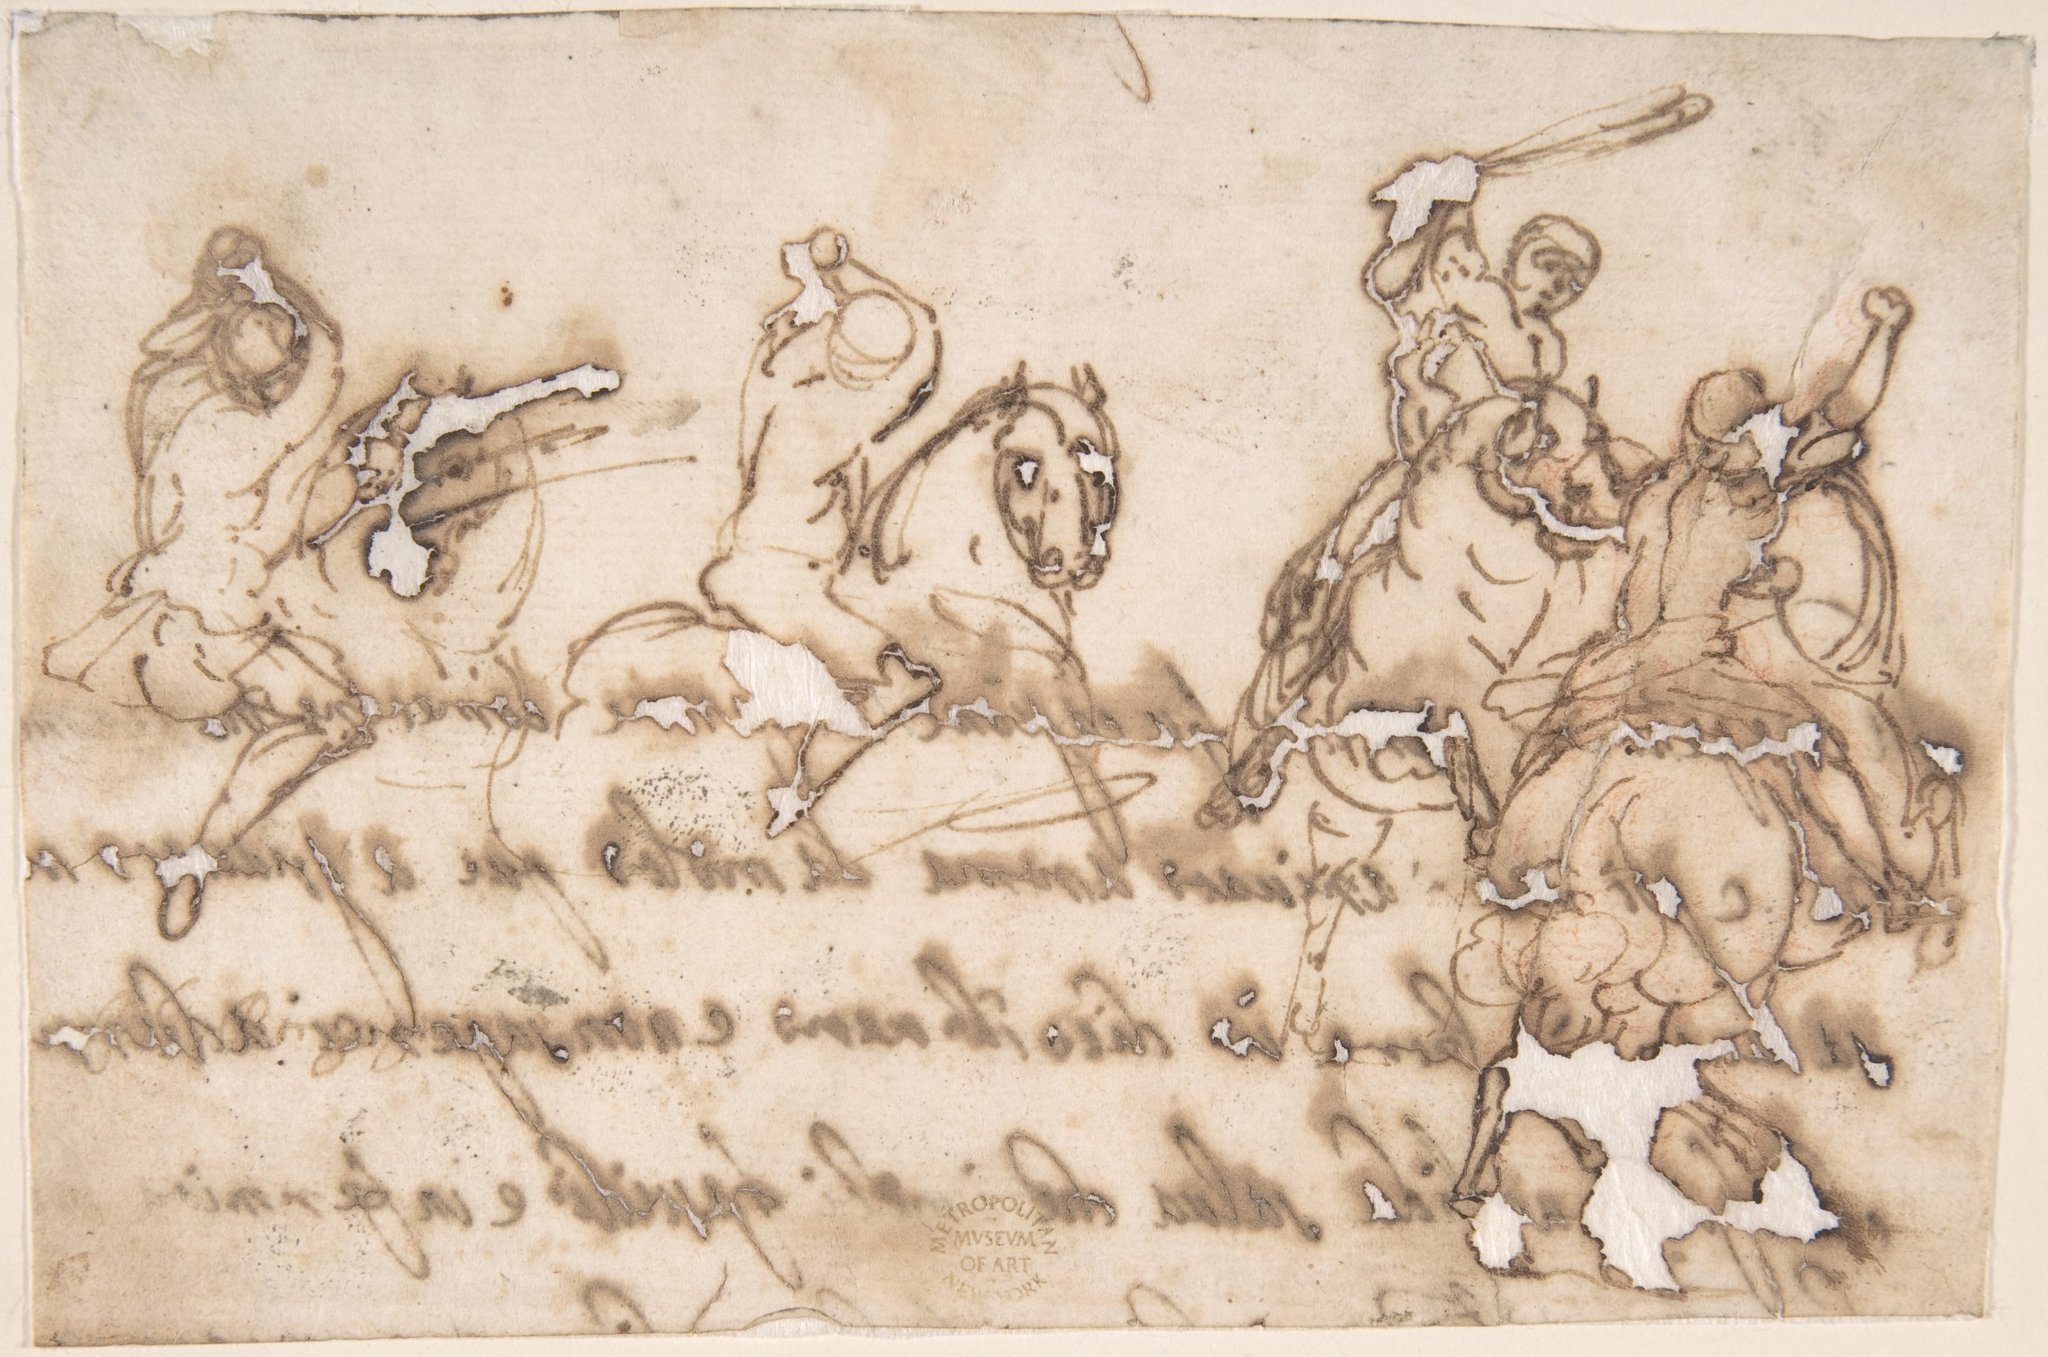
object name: drawing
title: Horsemen Fighting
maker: anonymous, italian, roman-bolognese, 17th century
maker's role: artist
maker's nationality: italian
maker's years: 1600-1700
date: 1601-1700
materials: chalk, ink, iron, paper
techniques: pen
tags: battles,men,horses